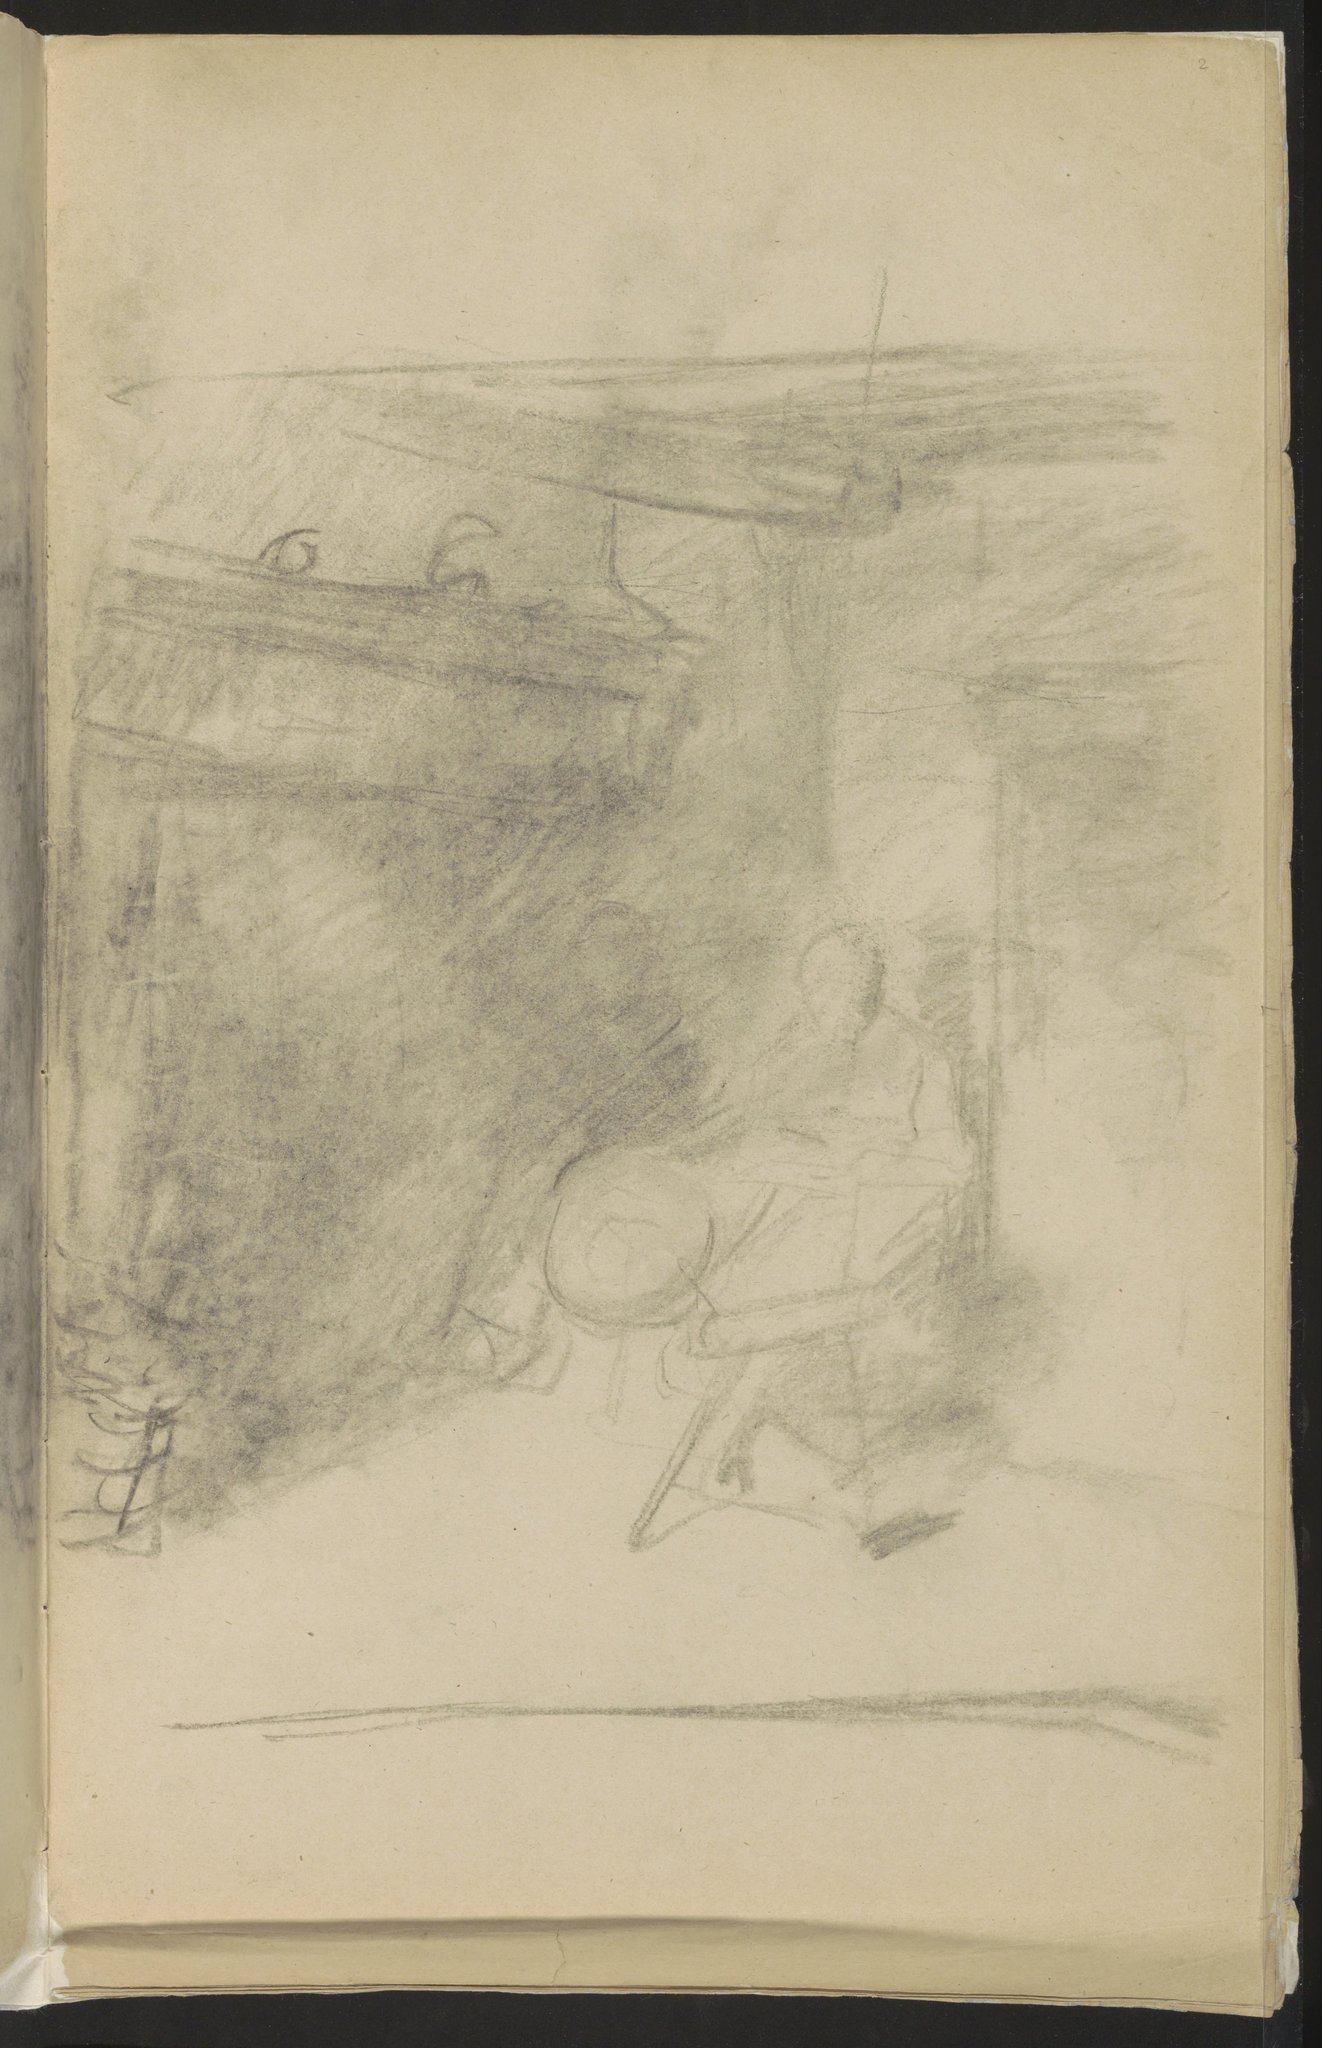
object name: sketchbook leaf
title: Handwerkende vrouw in een boereninterieur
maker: albert neuhuys (1844-1914)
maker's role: draughtsman, painter, print maker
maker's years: 1844-1914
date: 1854-1914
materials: charcoal, paper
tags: sitting figure, rural housing, e.g. country-house, villa, cottage, interior of the house, home sewing; repair of clothes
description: Blad 2 recto uit een schetsboek met 53 bladen.